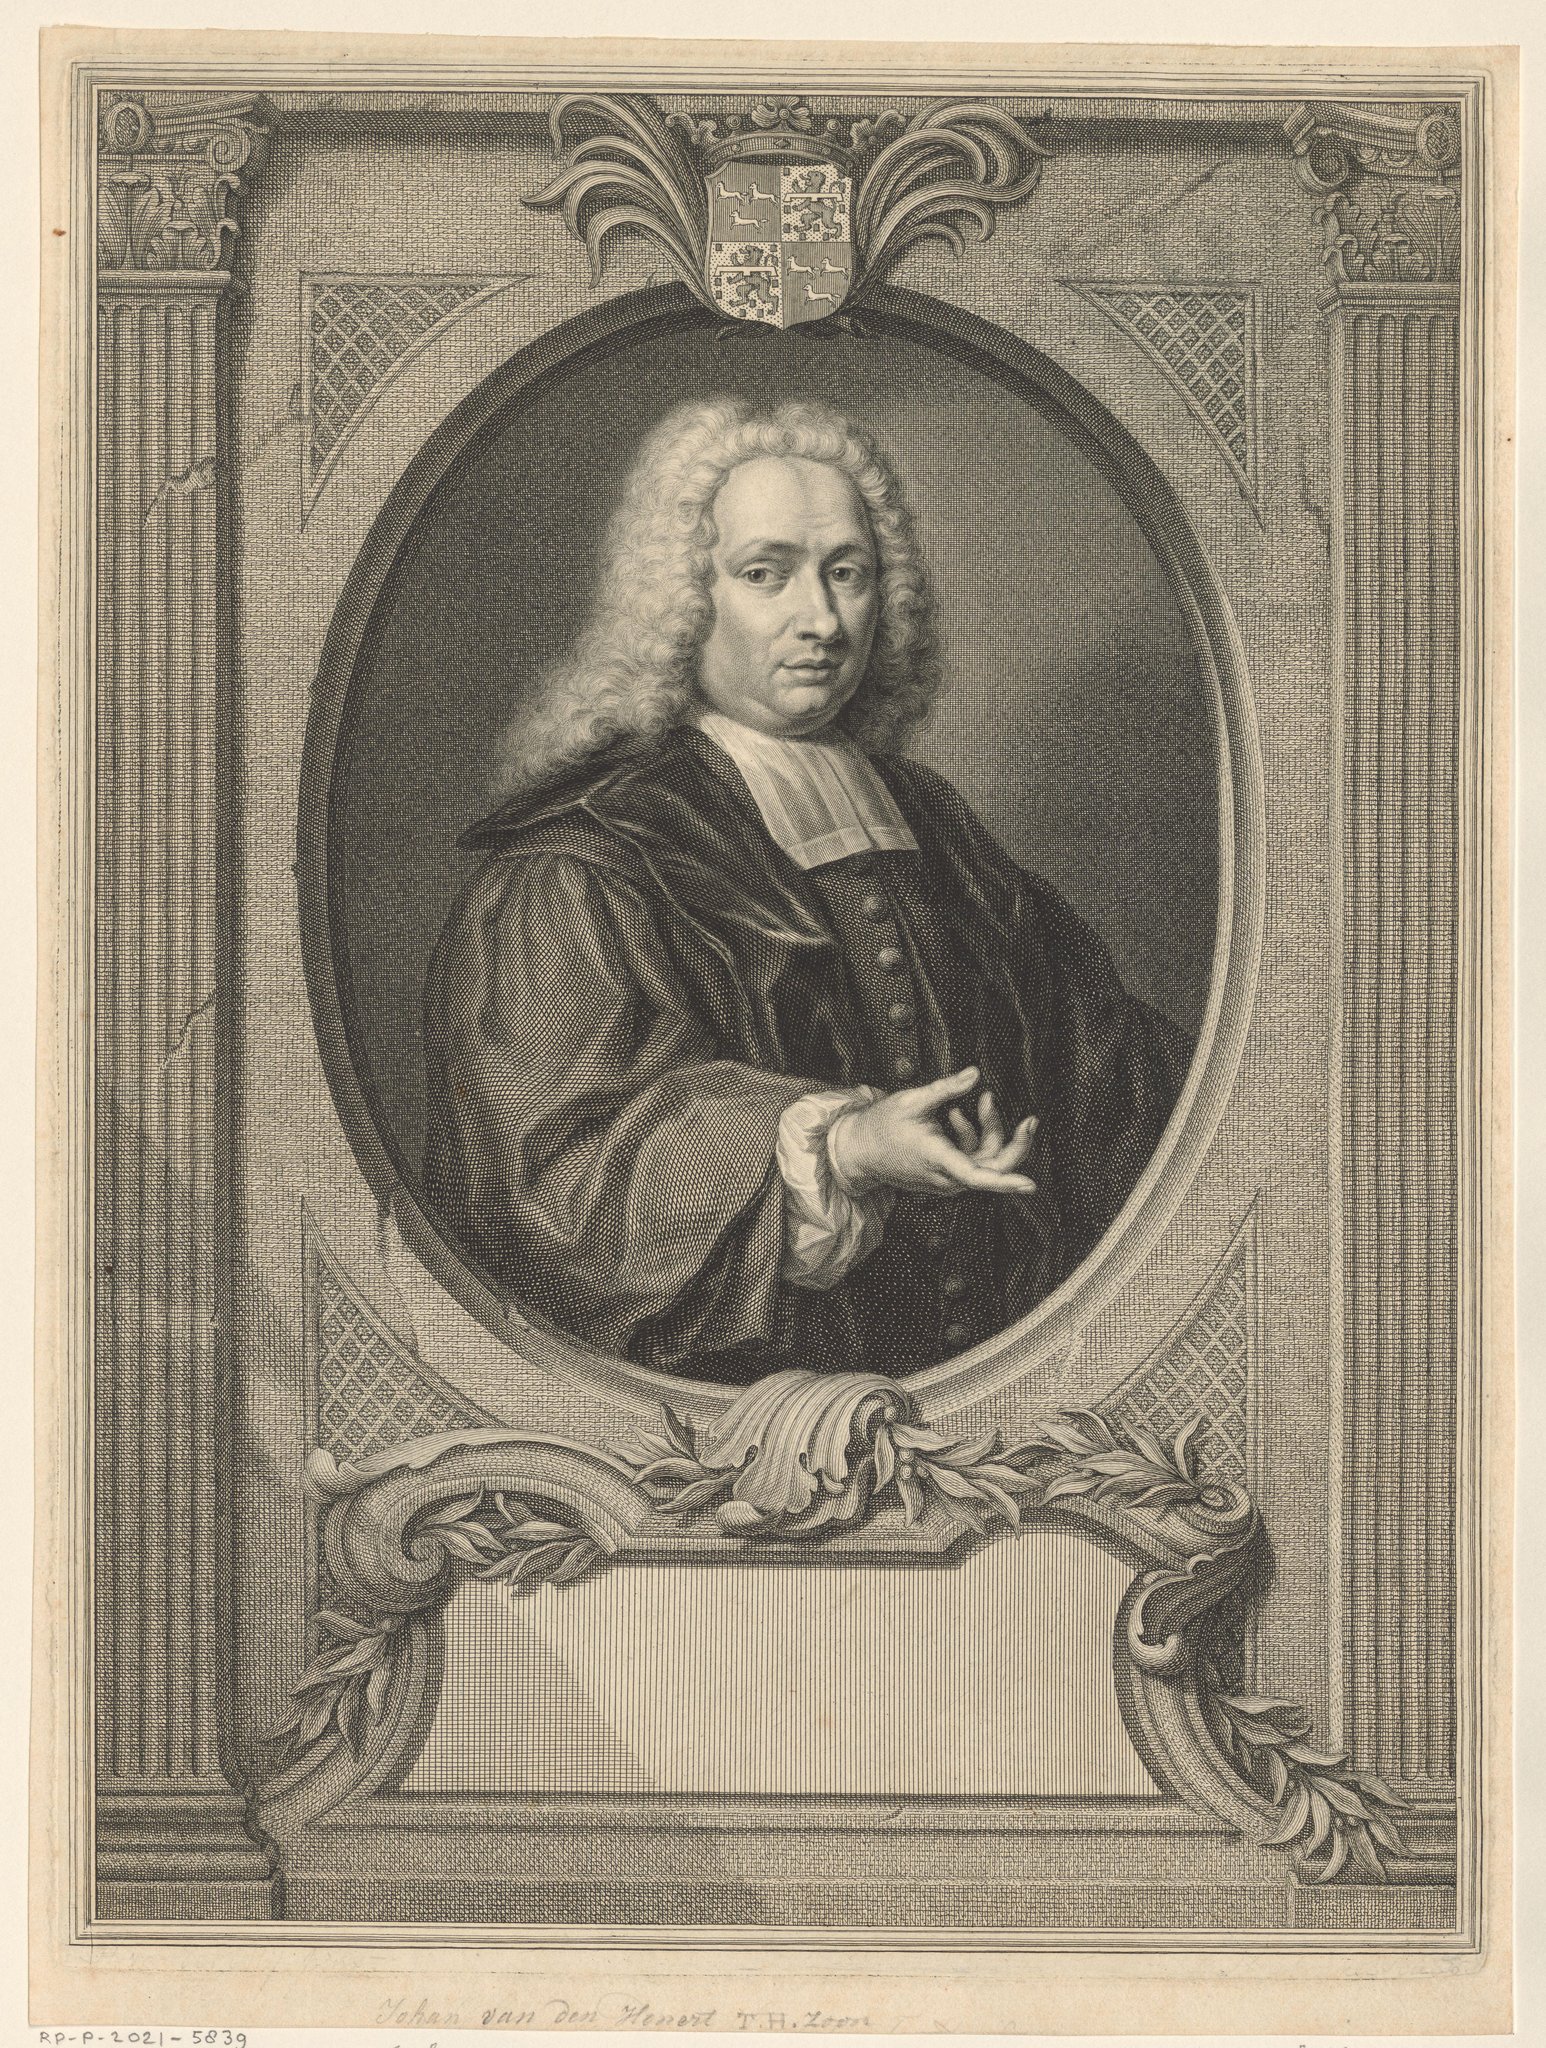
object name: print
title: Portret van Joan van den Honert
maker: jacob houbraken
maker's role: draughtsman, print maker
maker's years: 1698-1780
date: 1738-1780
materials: paper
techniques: engraving, etching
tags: leiden, theologian, historical persons, armorial bearing, heraldry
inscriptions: bookplate: ‘Nec timide nec tumide’, collector's mark: Lugt 2228